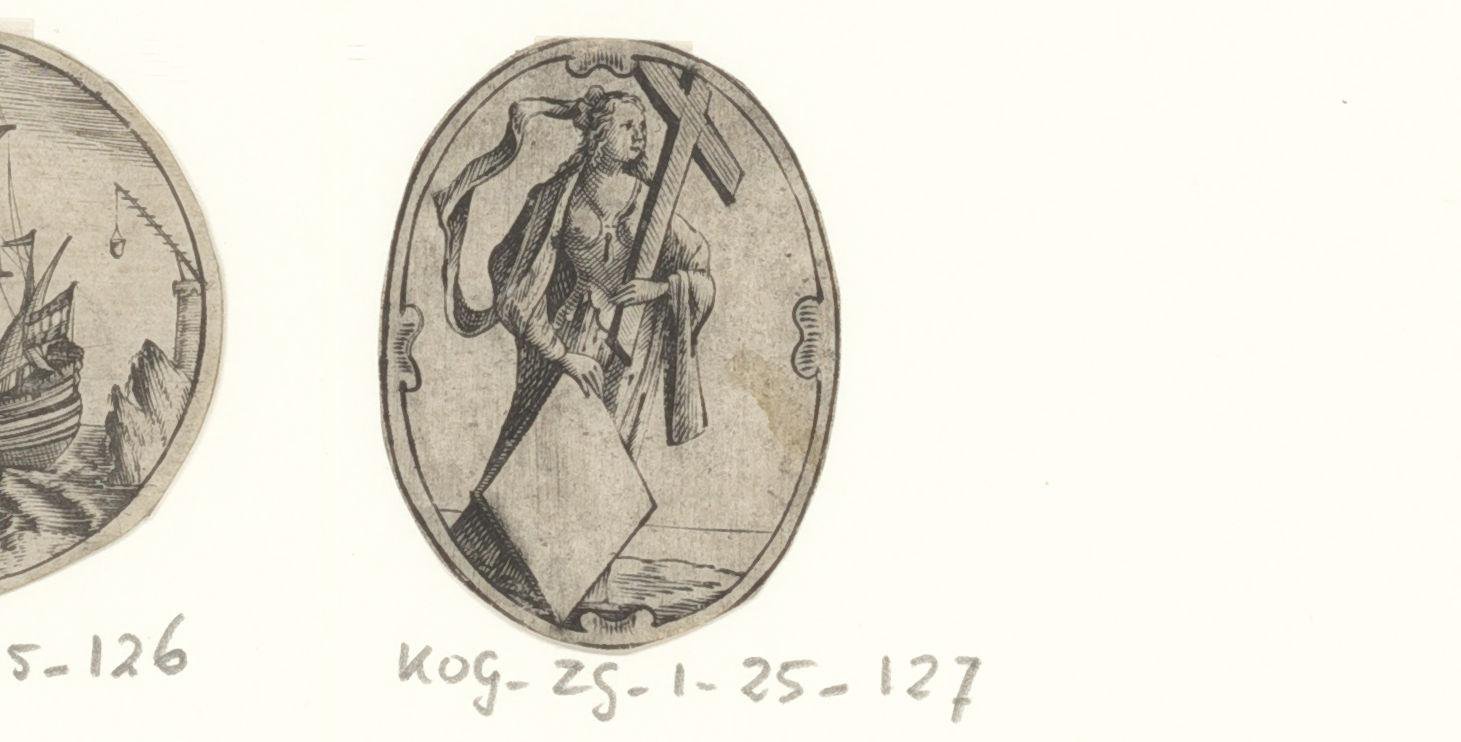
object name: print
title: Geloof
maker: Anonymous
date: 1600-1699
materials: paper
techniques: engraving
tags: fides (faith) as roman personification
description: Onderwerpsrubrieken binnen de Atlas Zeden en Gewoonten: Zeden en Gewoonten in Engeren Zin, De Woning, Huisraad, Zilverwerk.